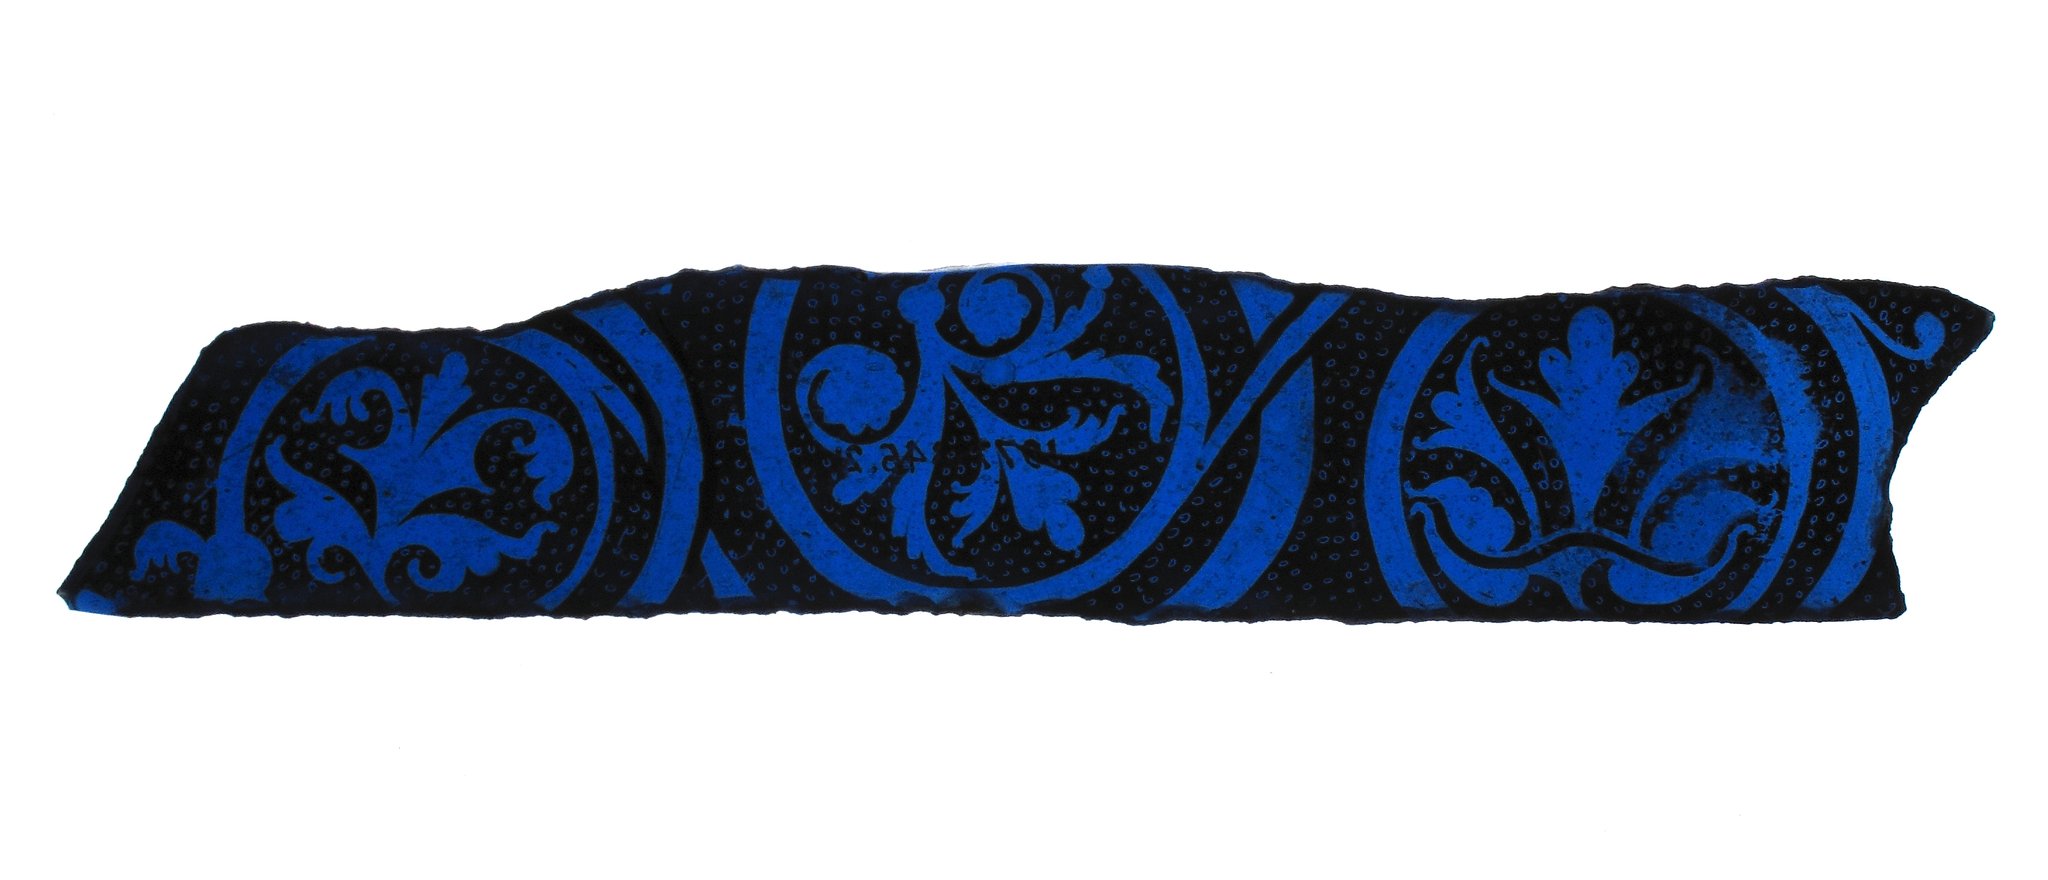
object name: fragment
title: Glass Fragment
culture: french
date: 1101-1400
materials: glass, metal, paint